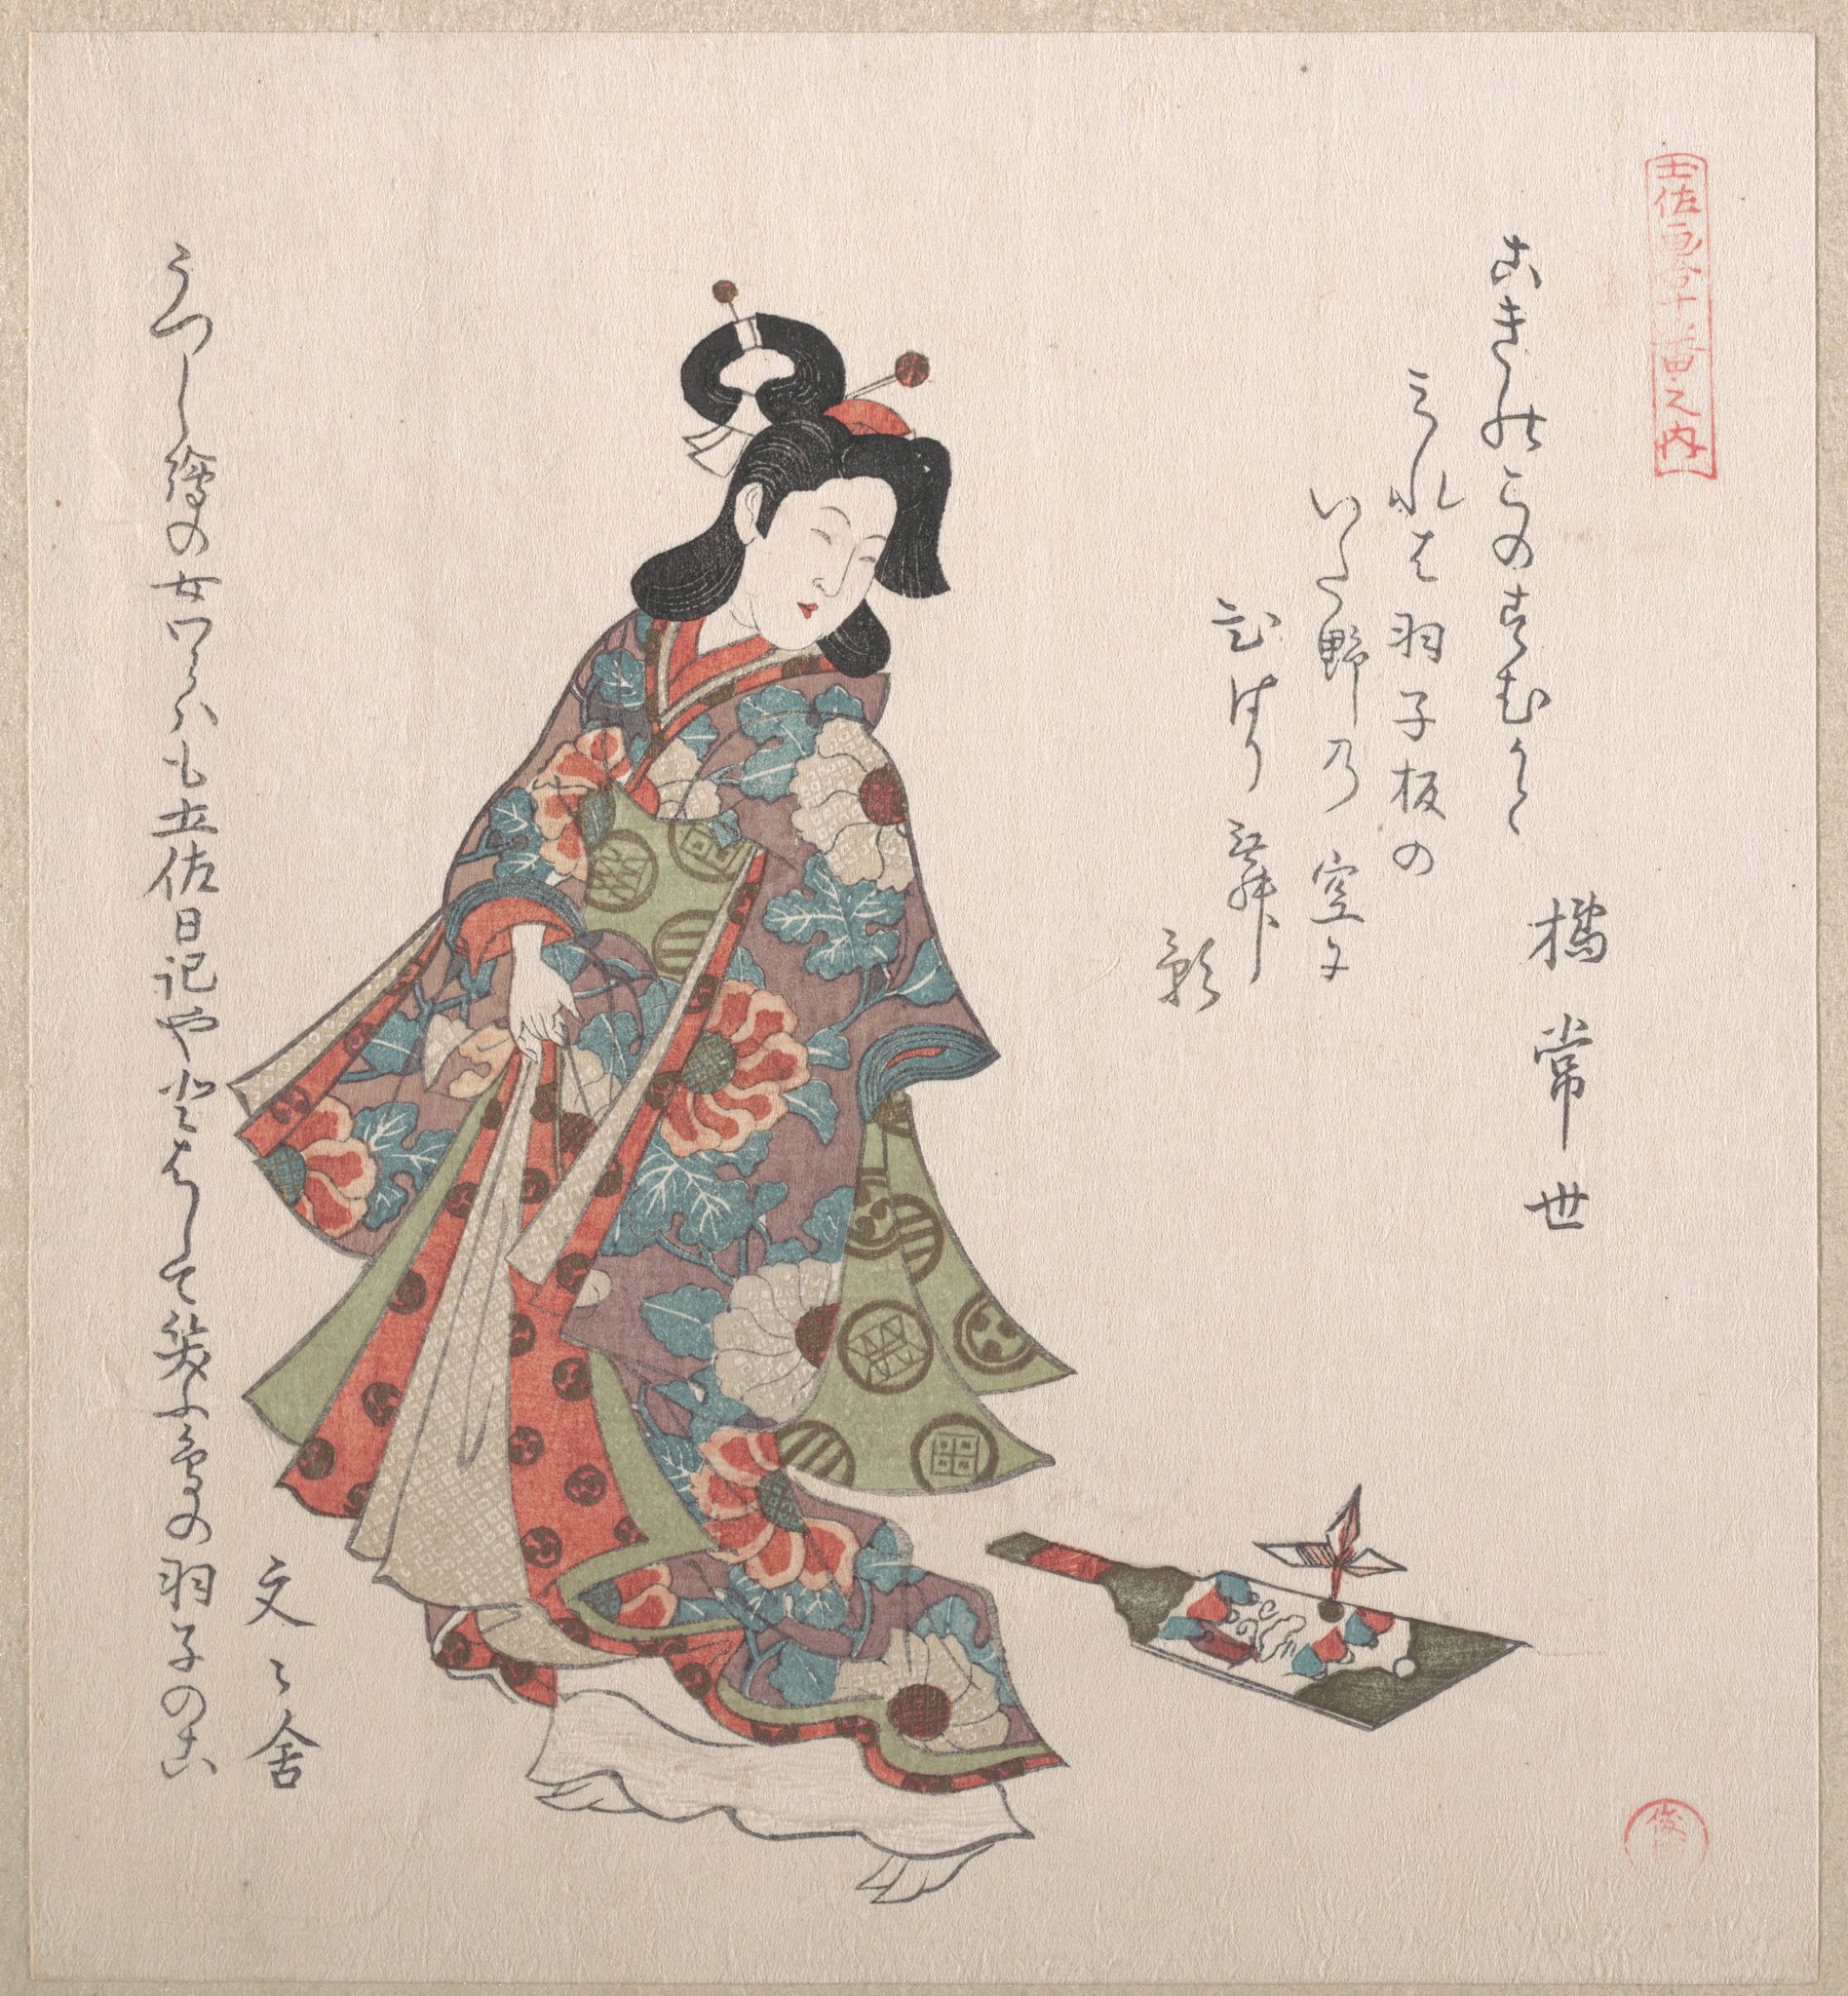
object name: print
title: Girl and a Hagoita (Japanese Battledore and Shuttlecock)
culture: japanese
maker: kubo shunman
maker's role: artist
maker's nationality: japanese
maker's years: 1757-1820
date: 1815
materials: ink, paper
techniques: surimono, woodblock print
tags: girls